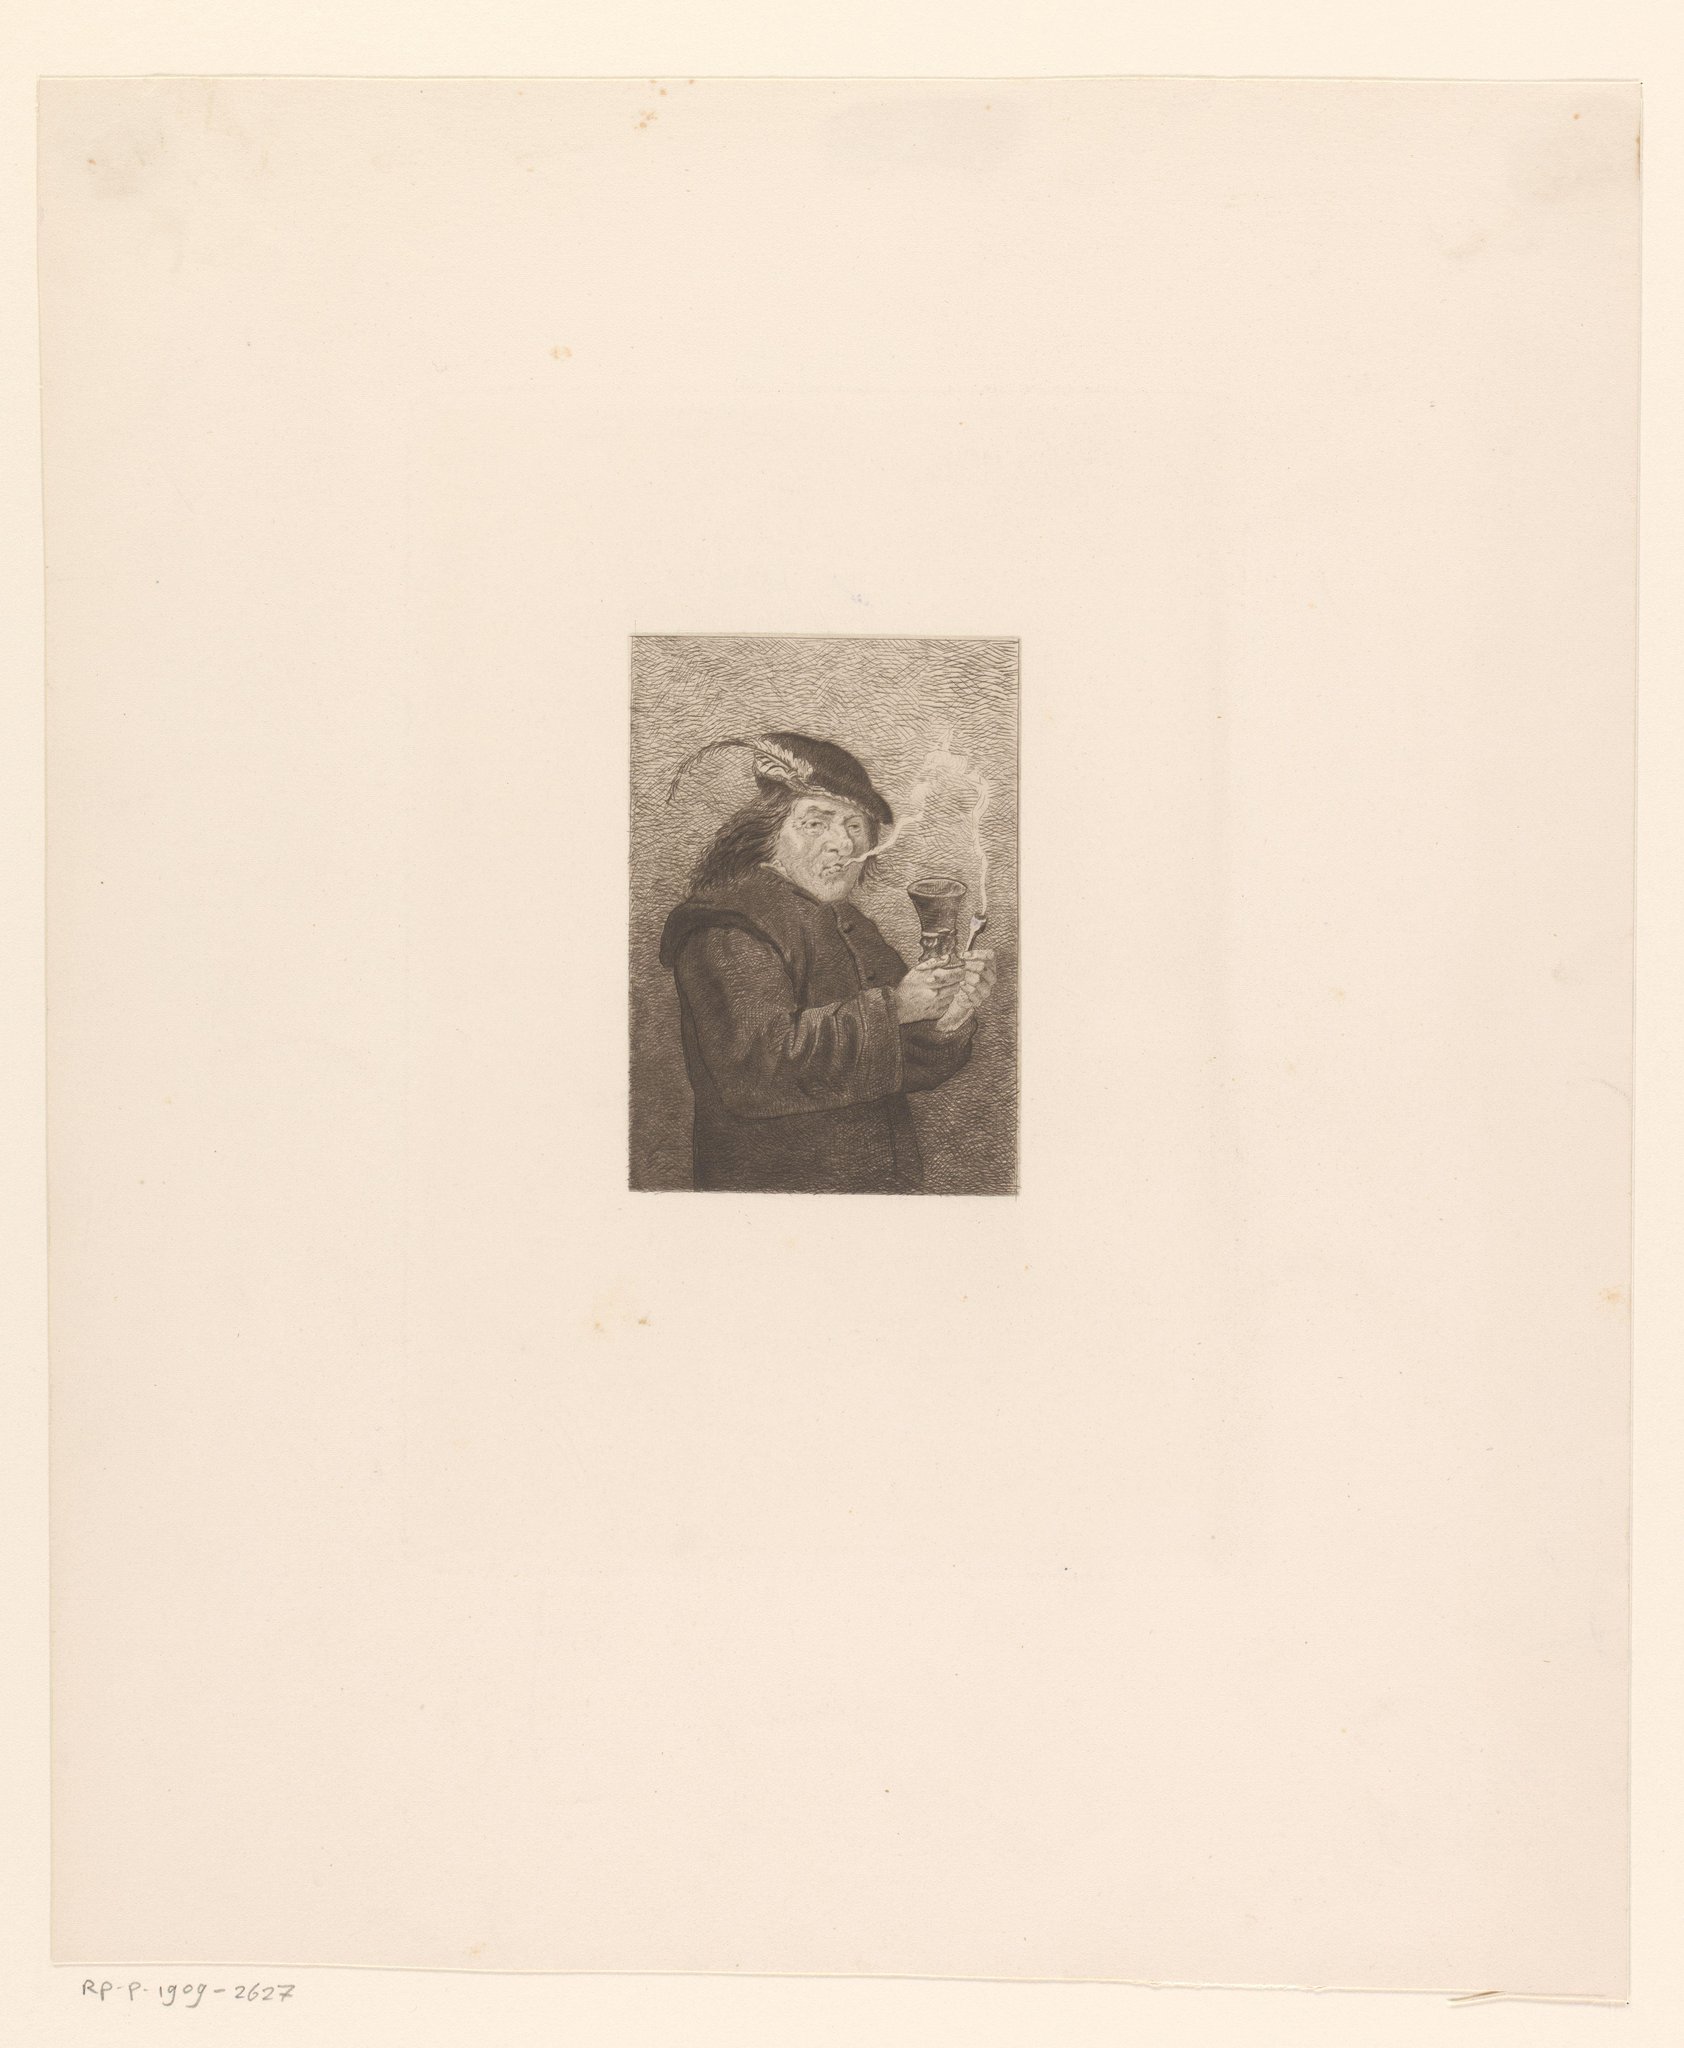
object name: print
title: Rokende man met drinkbeker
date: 1873-1909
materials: paper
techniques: drypoint, etching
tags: drinking, tobacco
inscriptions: collector's mark: Lugt 2228